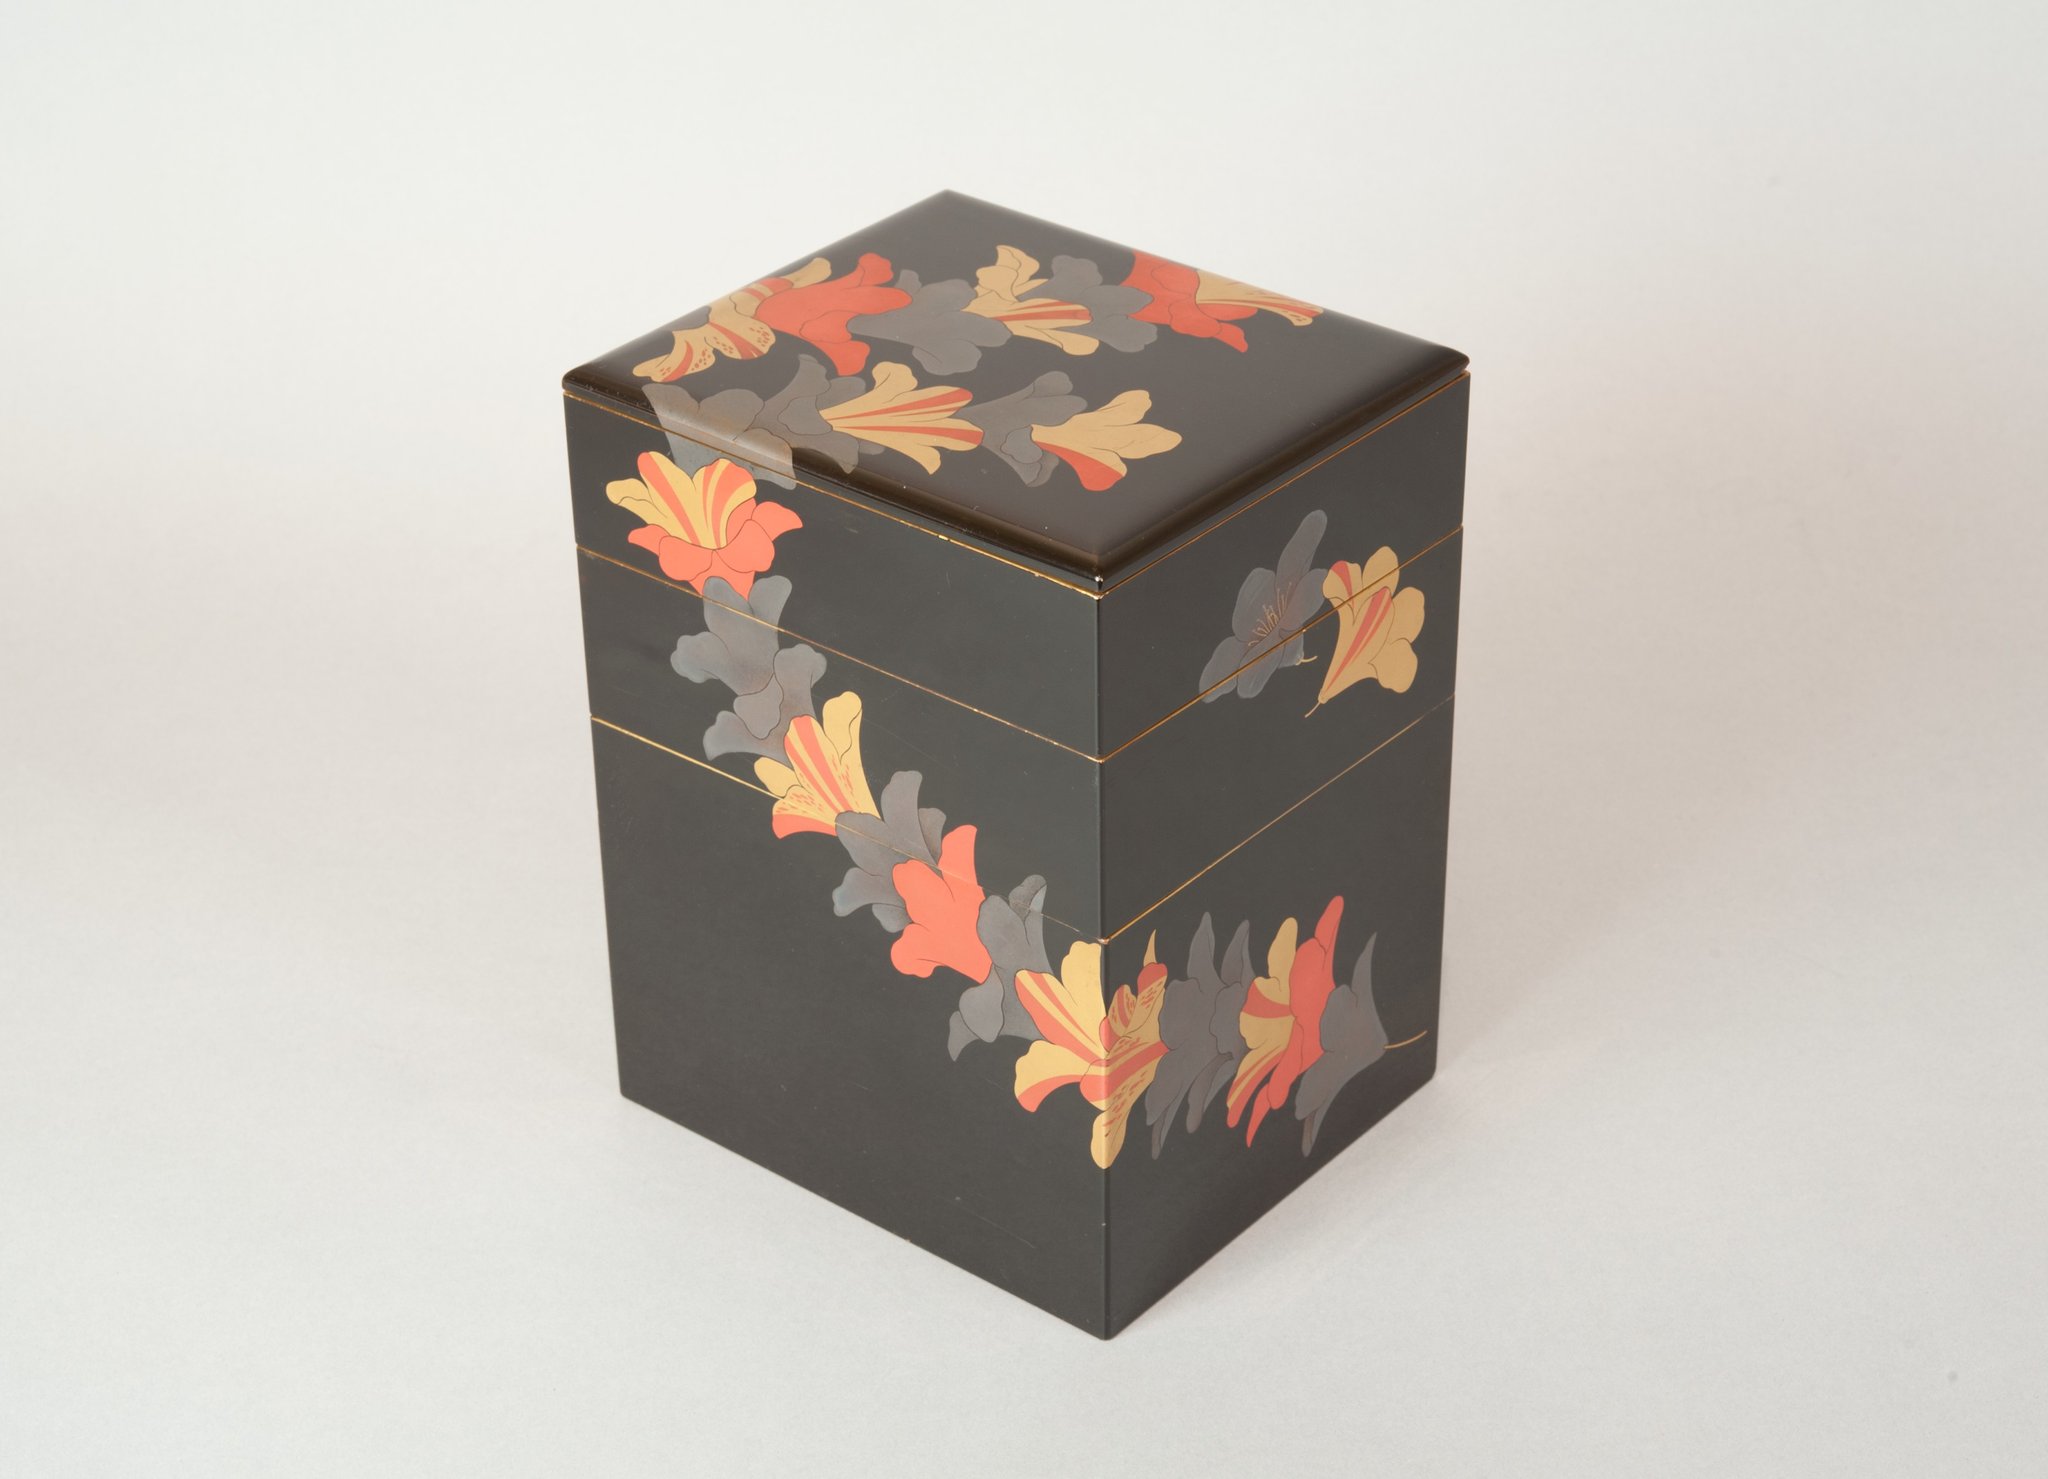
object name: food box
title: Tiered Food Box (Jūbako) with Garland of Azaleas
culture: japanese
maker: yamamoto shunshō school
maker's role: artist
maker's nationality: japanese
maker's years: 1610-1682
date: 1901-1933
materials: gold, silver, wood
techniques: lacquer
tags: flowers